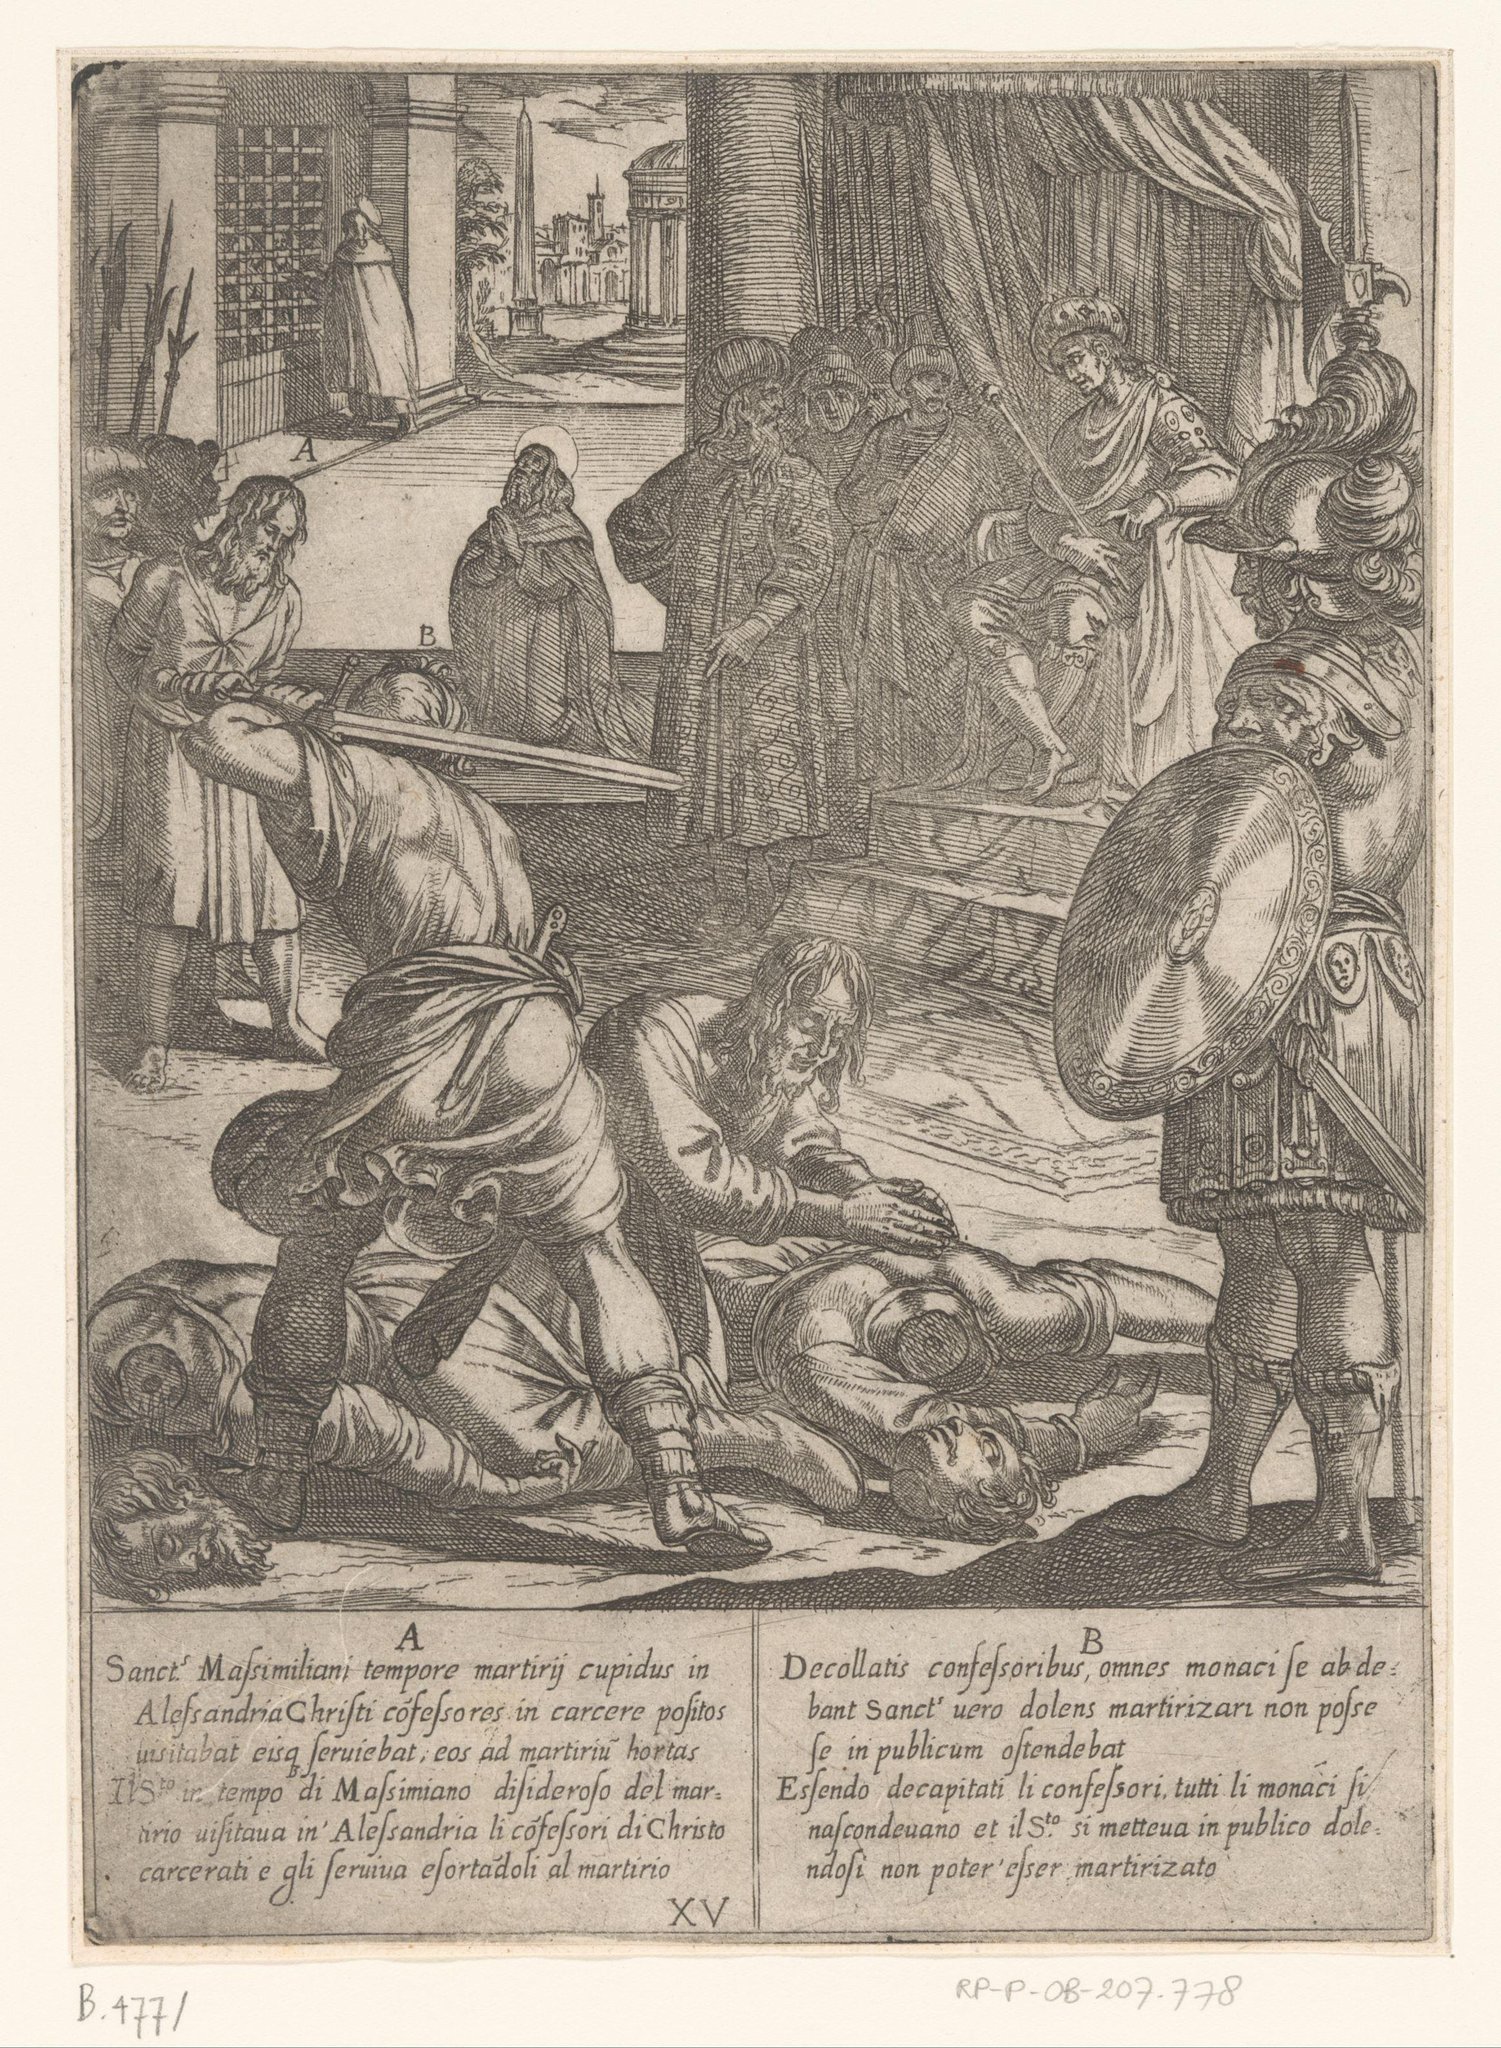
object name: print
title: H. Antonius bezoekt christenen die gevangengenomen zijn door Maximilianus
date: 1598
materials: paper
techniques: etching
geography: italy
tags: prison, jail, the hermit antony abbot (antonius abbas) of egypt, also called the great; possible attributes: bell, book, t-shaped staff, flames, pig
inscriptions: collector's mark: Lugt 240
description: Deze prent maakt deel uit van een reeks van 27 prenten (+ titelprent) over het leven van de heilige Antonius, naar een frescocyclus in de S. Antonio Abbate in Rome door Giovanni Battista Lombardelli en Niccolò Circignani.